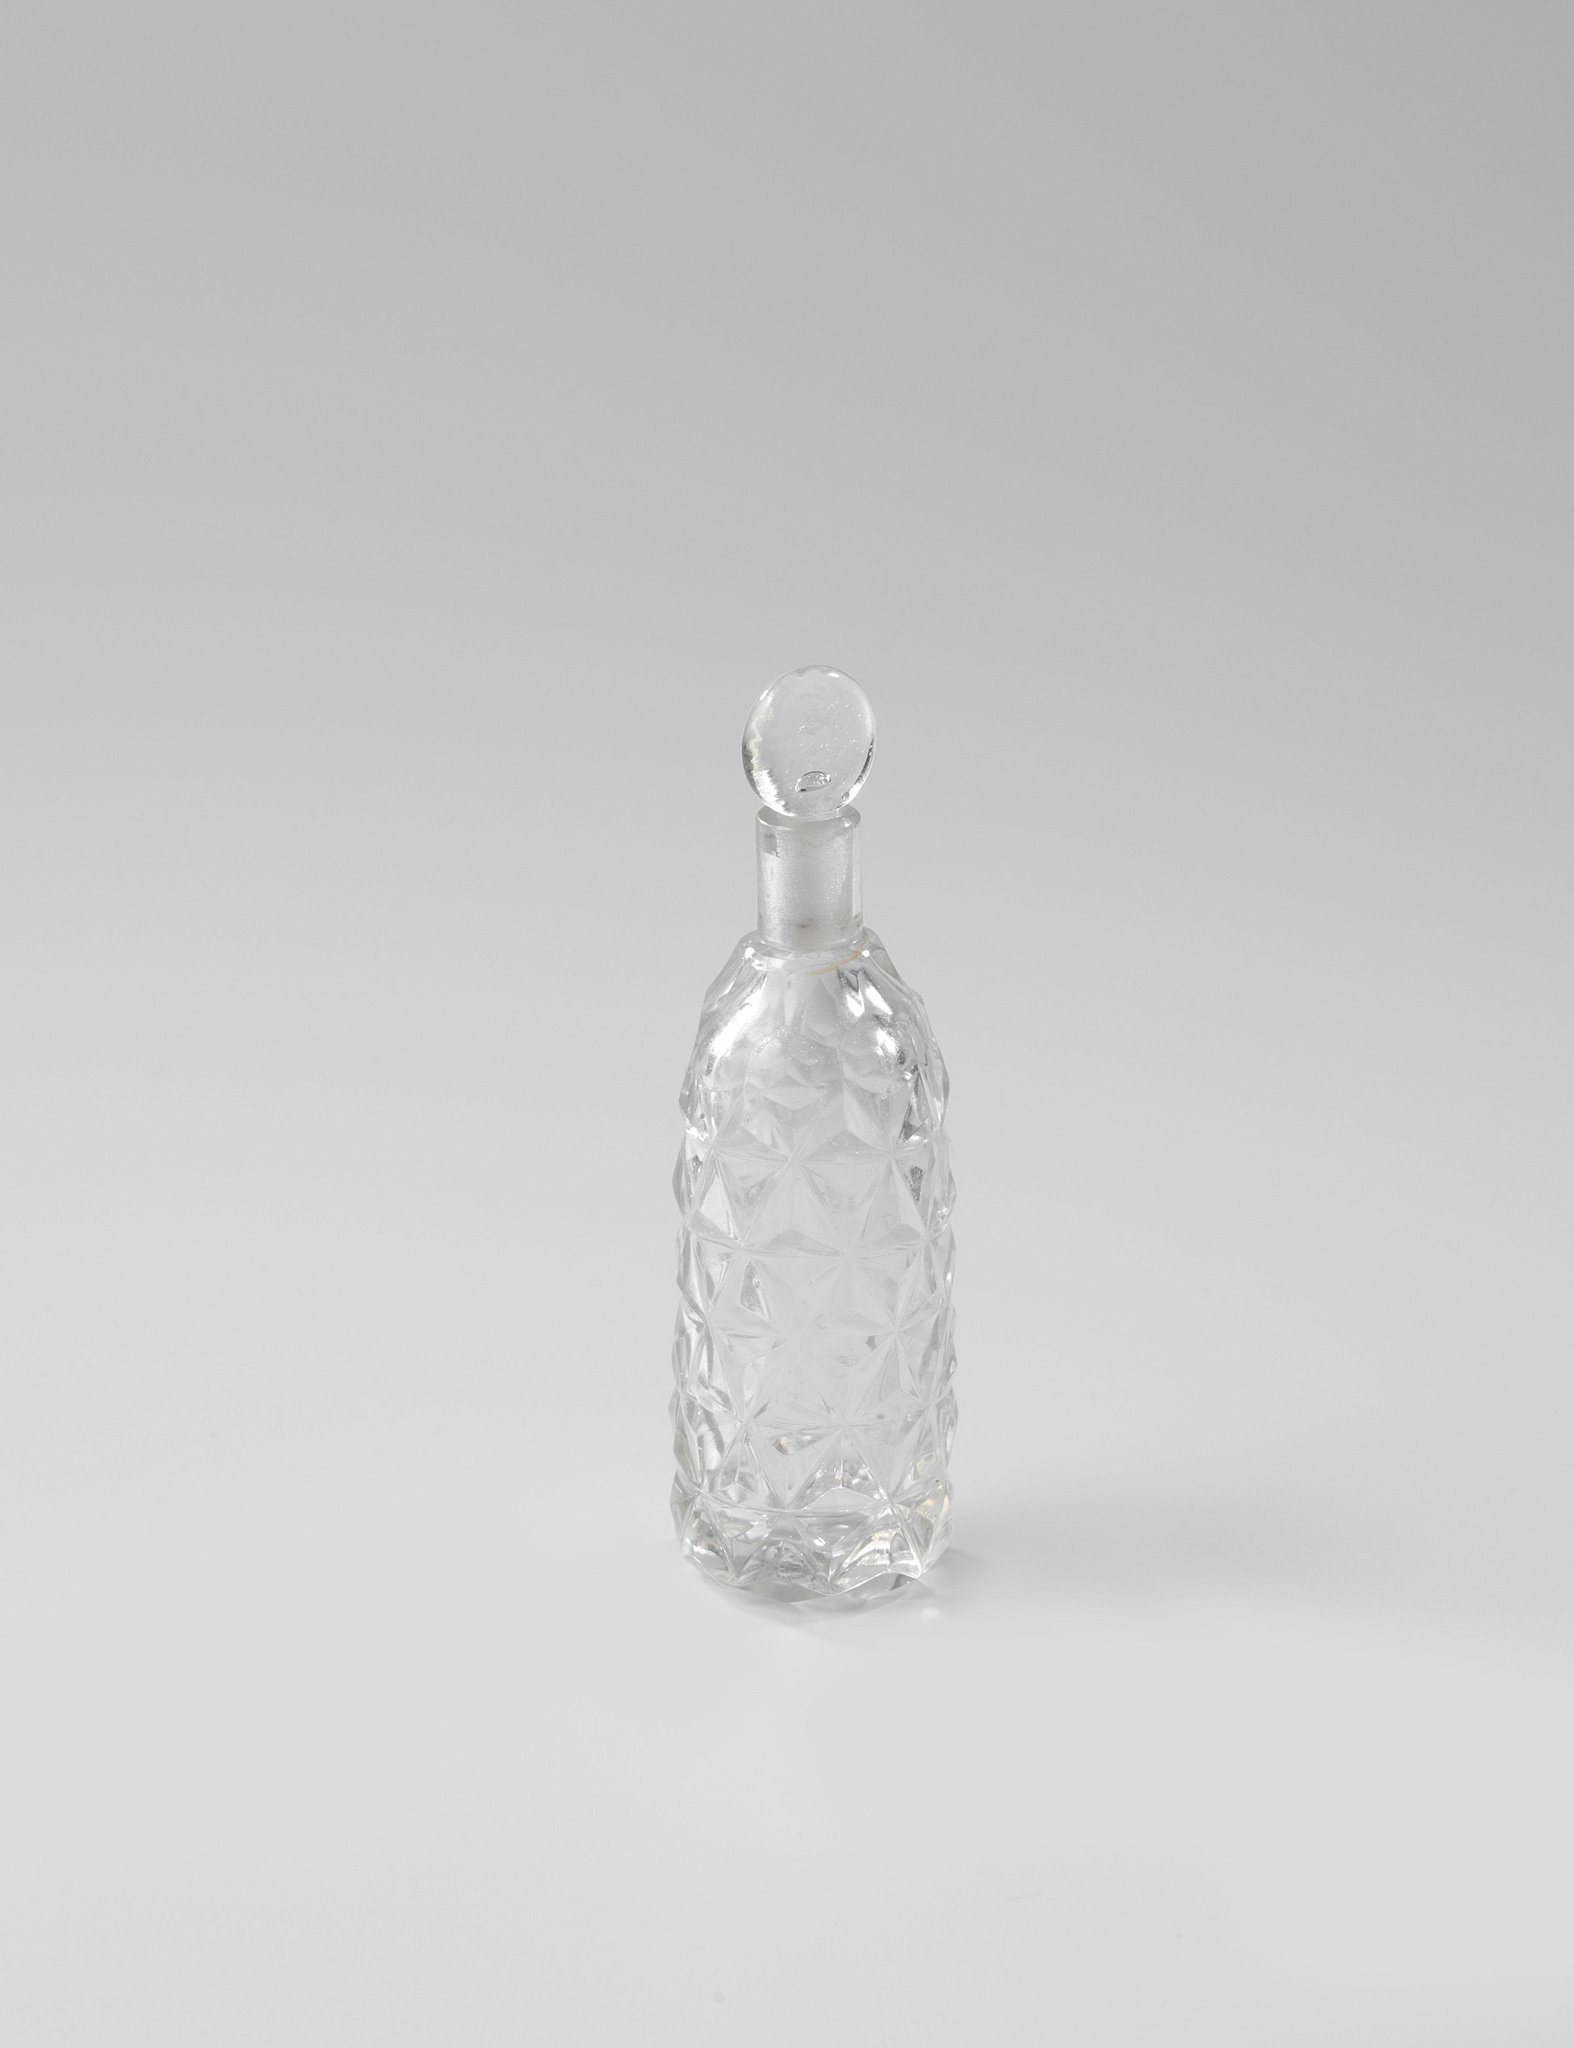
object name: perfume bottle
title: Parfumfles, met geslepen 'spitse' of 'scherpe' stenen, met een ronde stop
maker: Anonymous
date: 1400-1950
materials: glass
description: Parfumfles, rond, met geslepen 'spitse' of 'scherpe' stenen, met een ronde stop.